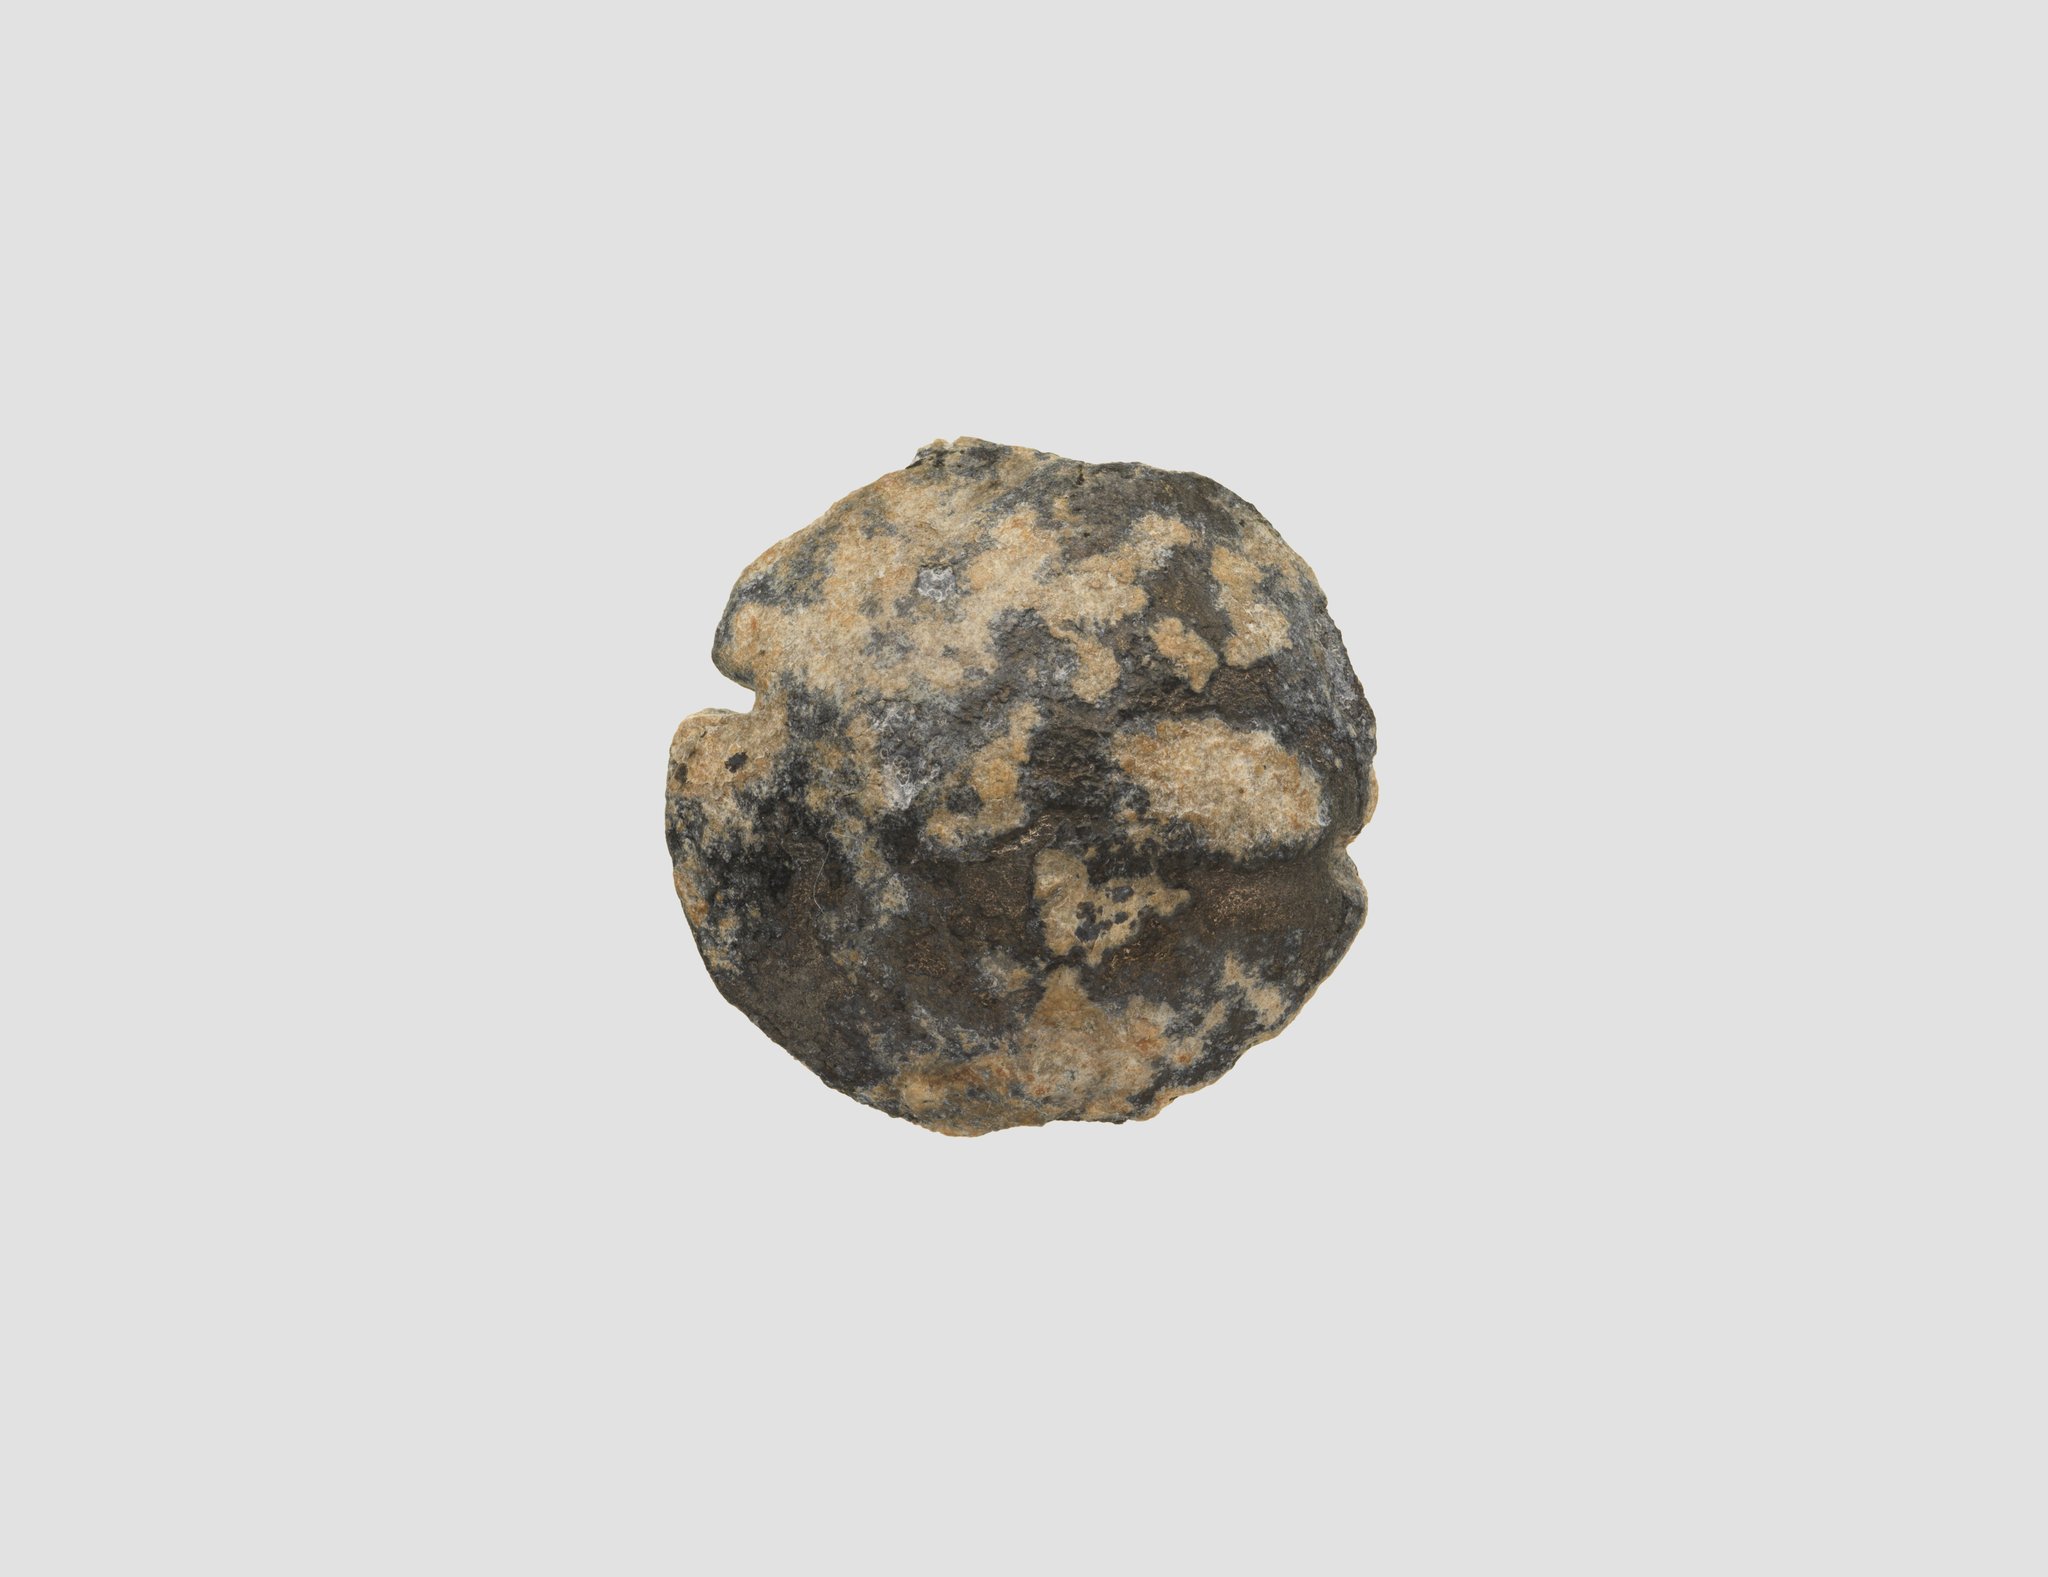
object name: bead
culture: iranian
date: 900-801 BCE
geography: iran